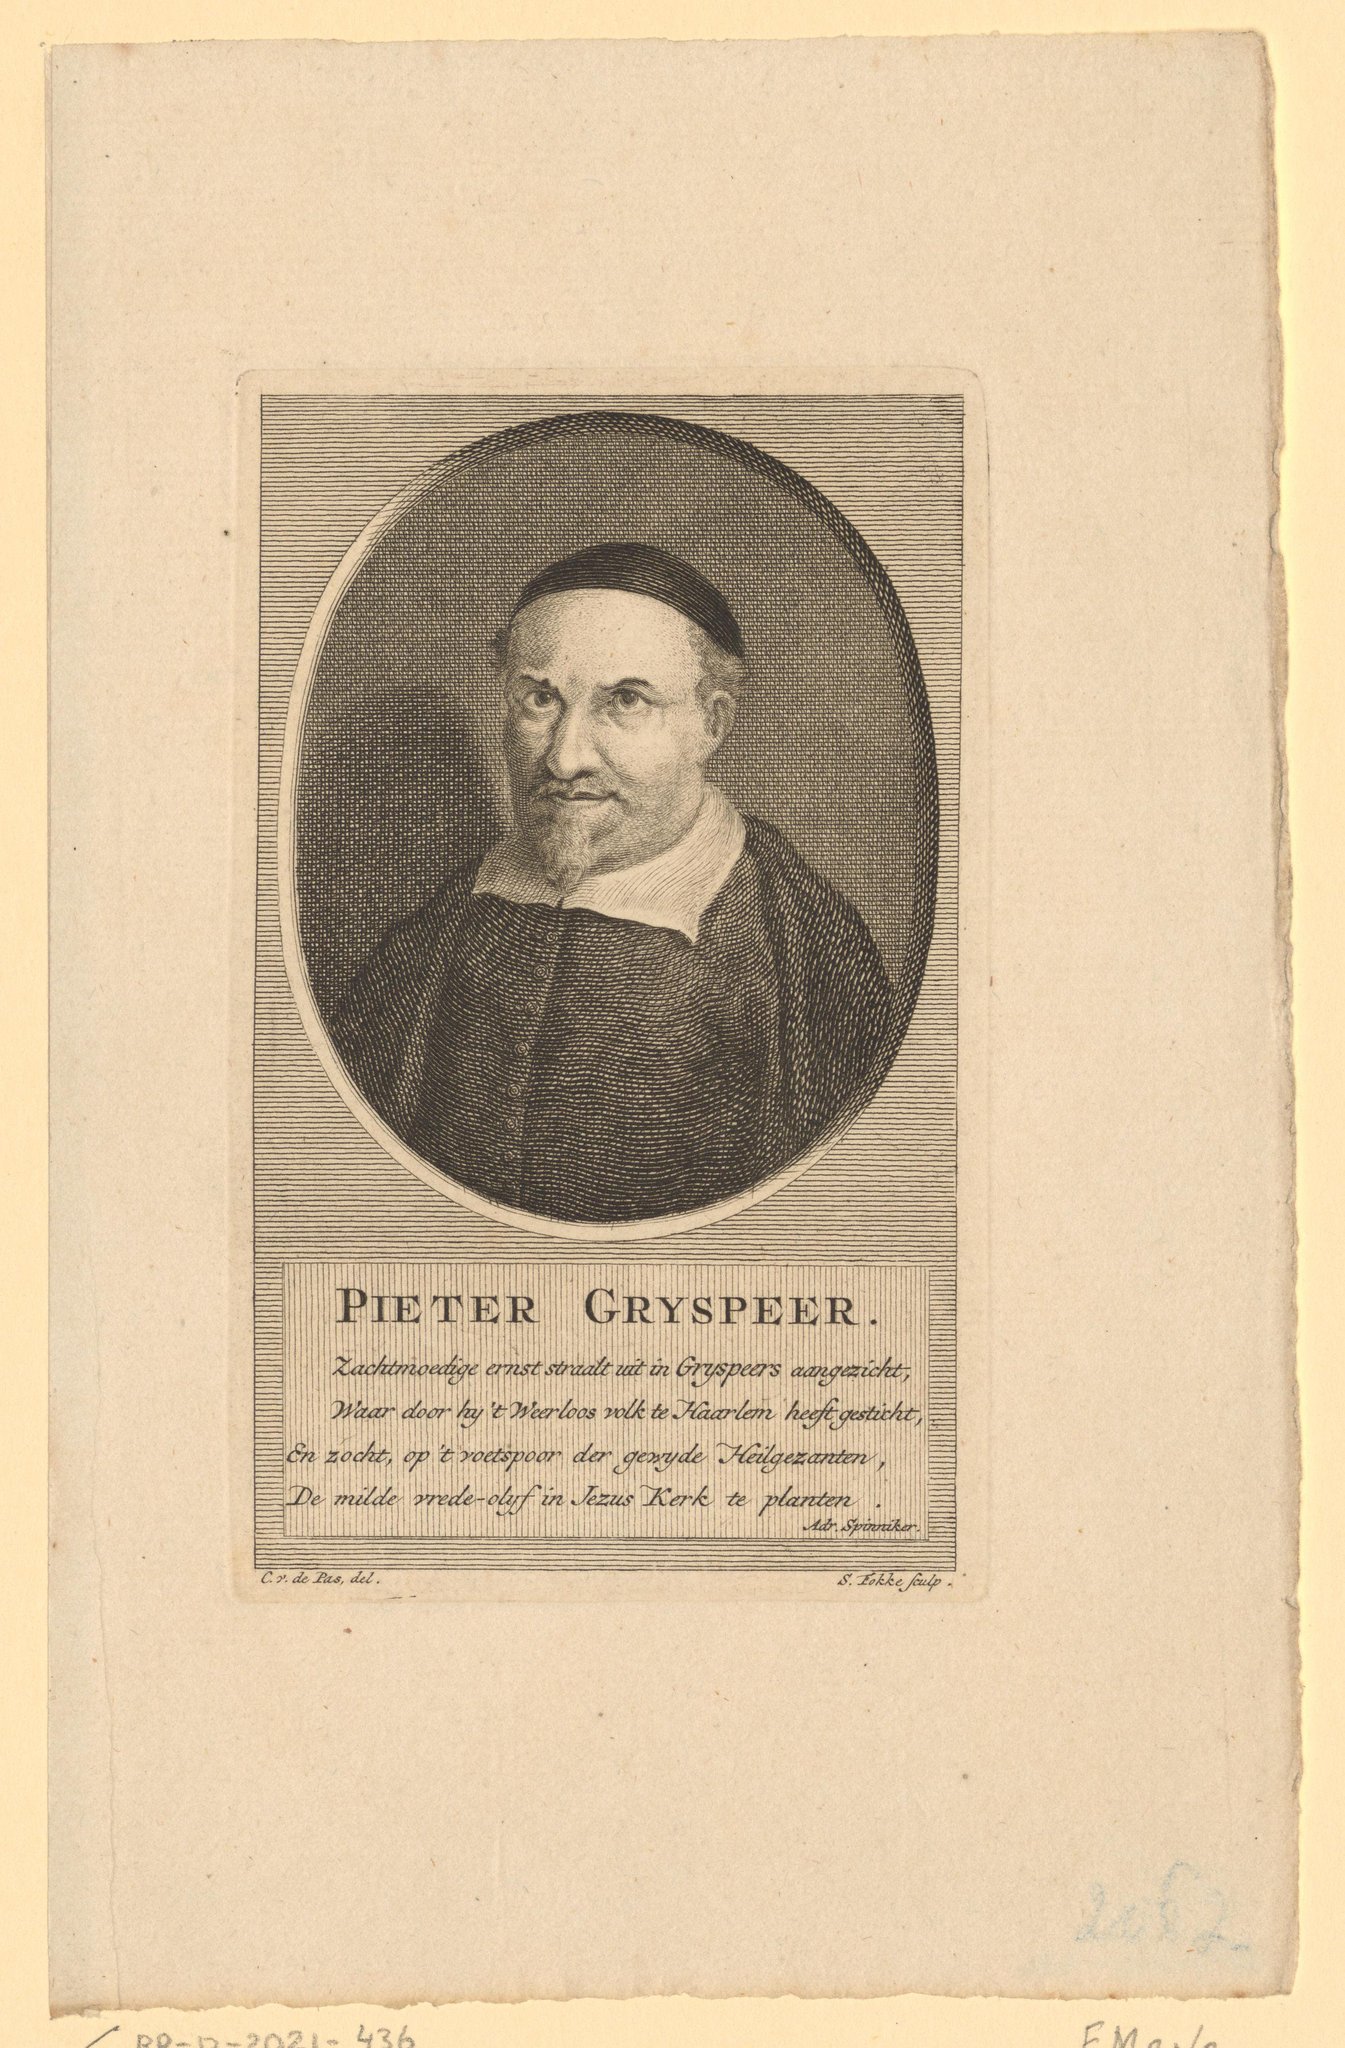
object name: print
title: Portret van Pieter Grijspeer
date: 1722-1743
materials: paper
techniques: engraving, etching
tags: theologian, further education, historical persons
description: Tekst in het Nederlands in de ondermarge.